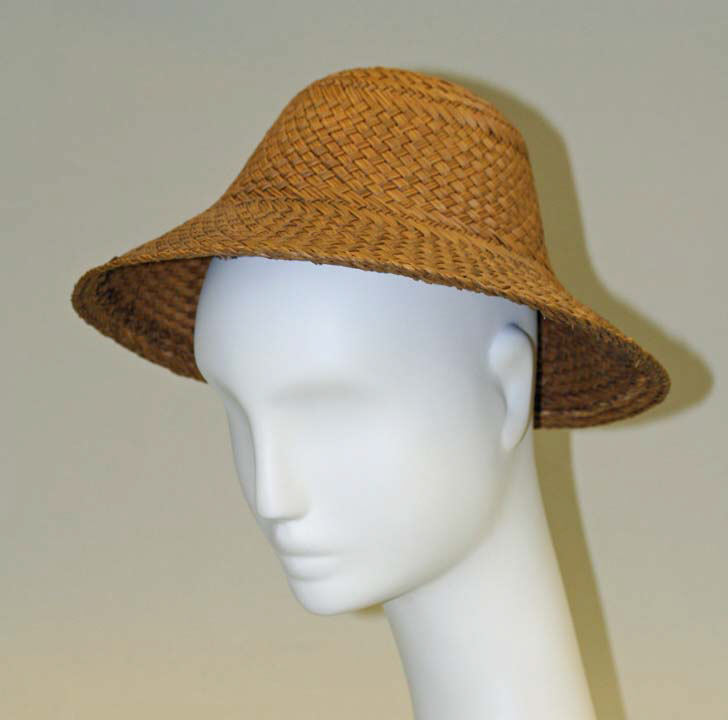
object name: hat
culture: american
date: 1867-1900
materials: fiber